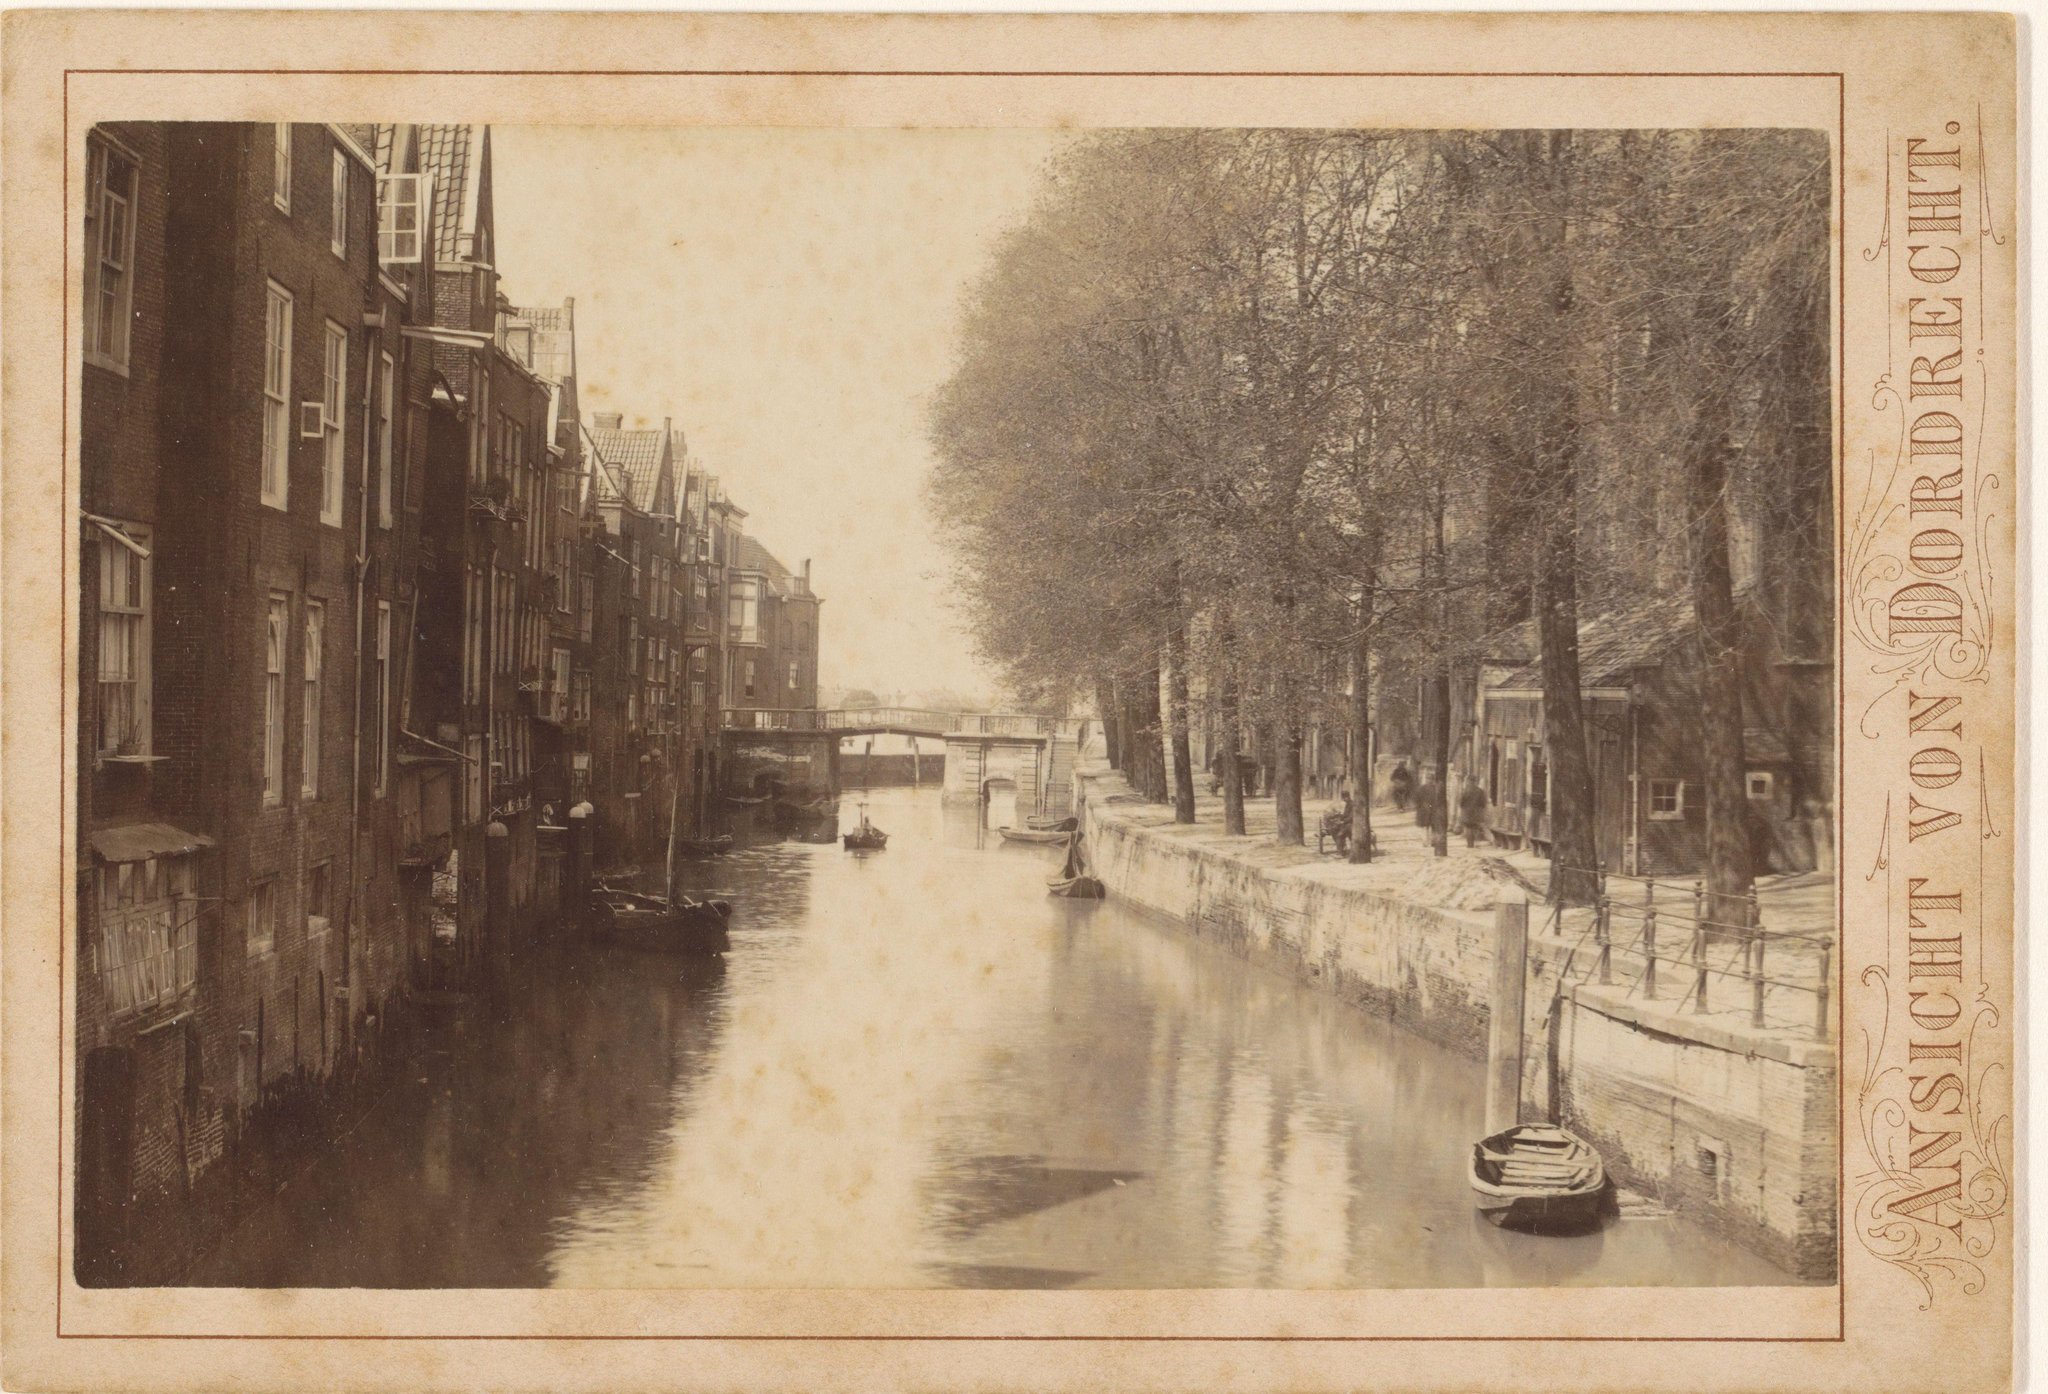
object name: photograph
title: Ansicht von Dordrecht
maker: Anonymous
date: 1860-1890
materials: cardboard, paper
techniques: albumen print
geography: dordrecht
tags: canals, waters (in city), dordrecht